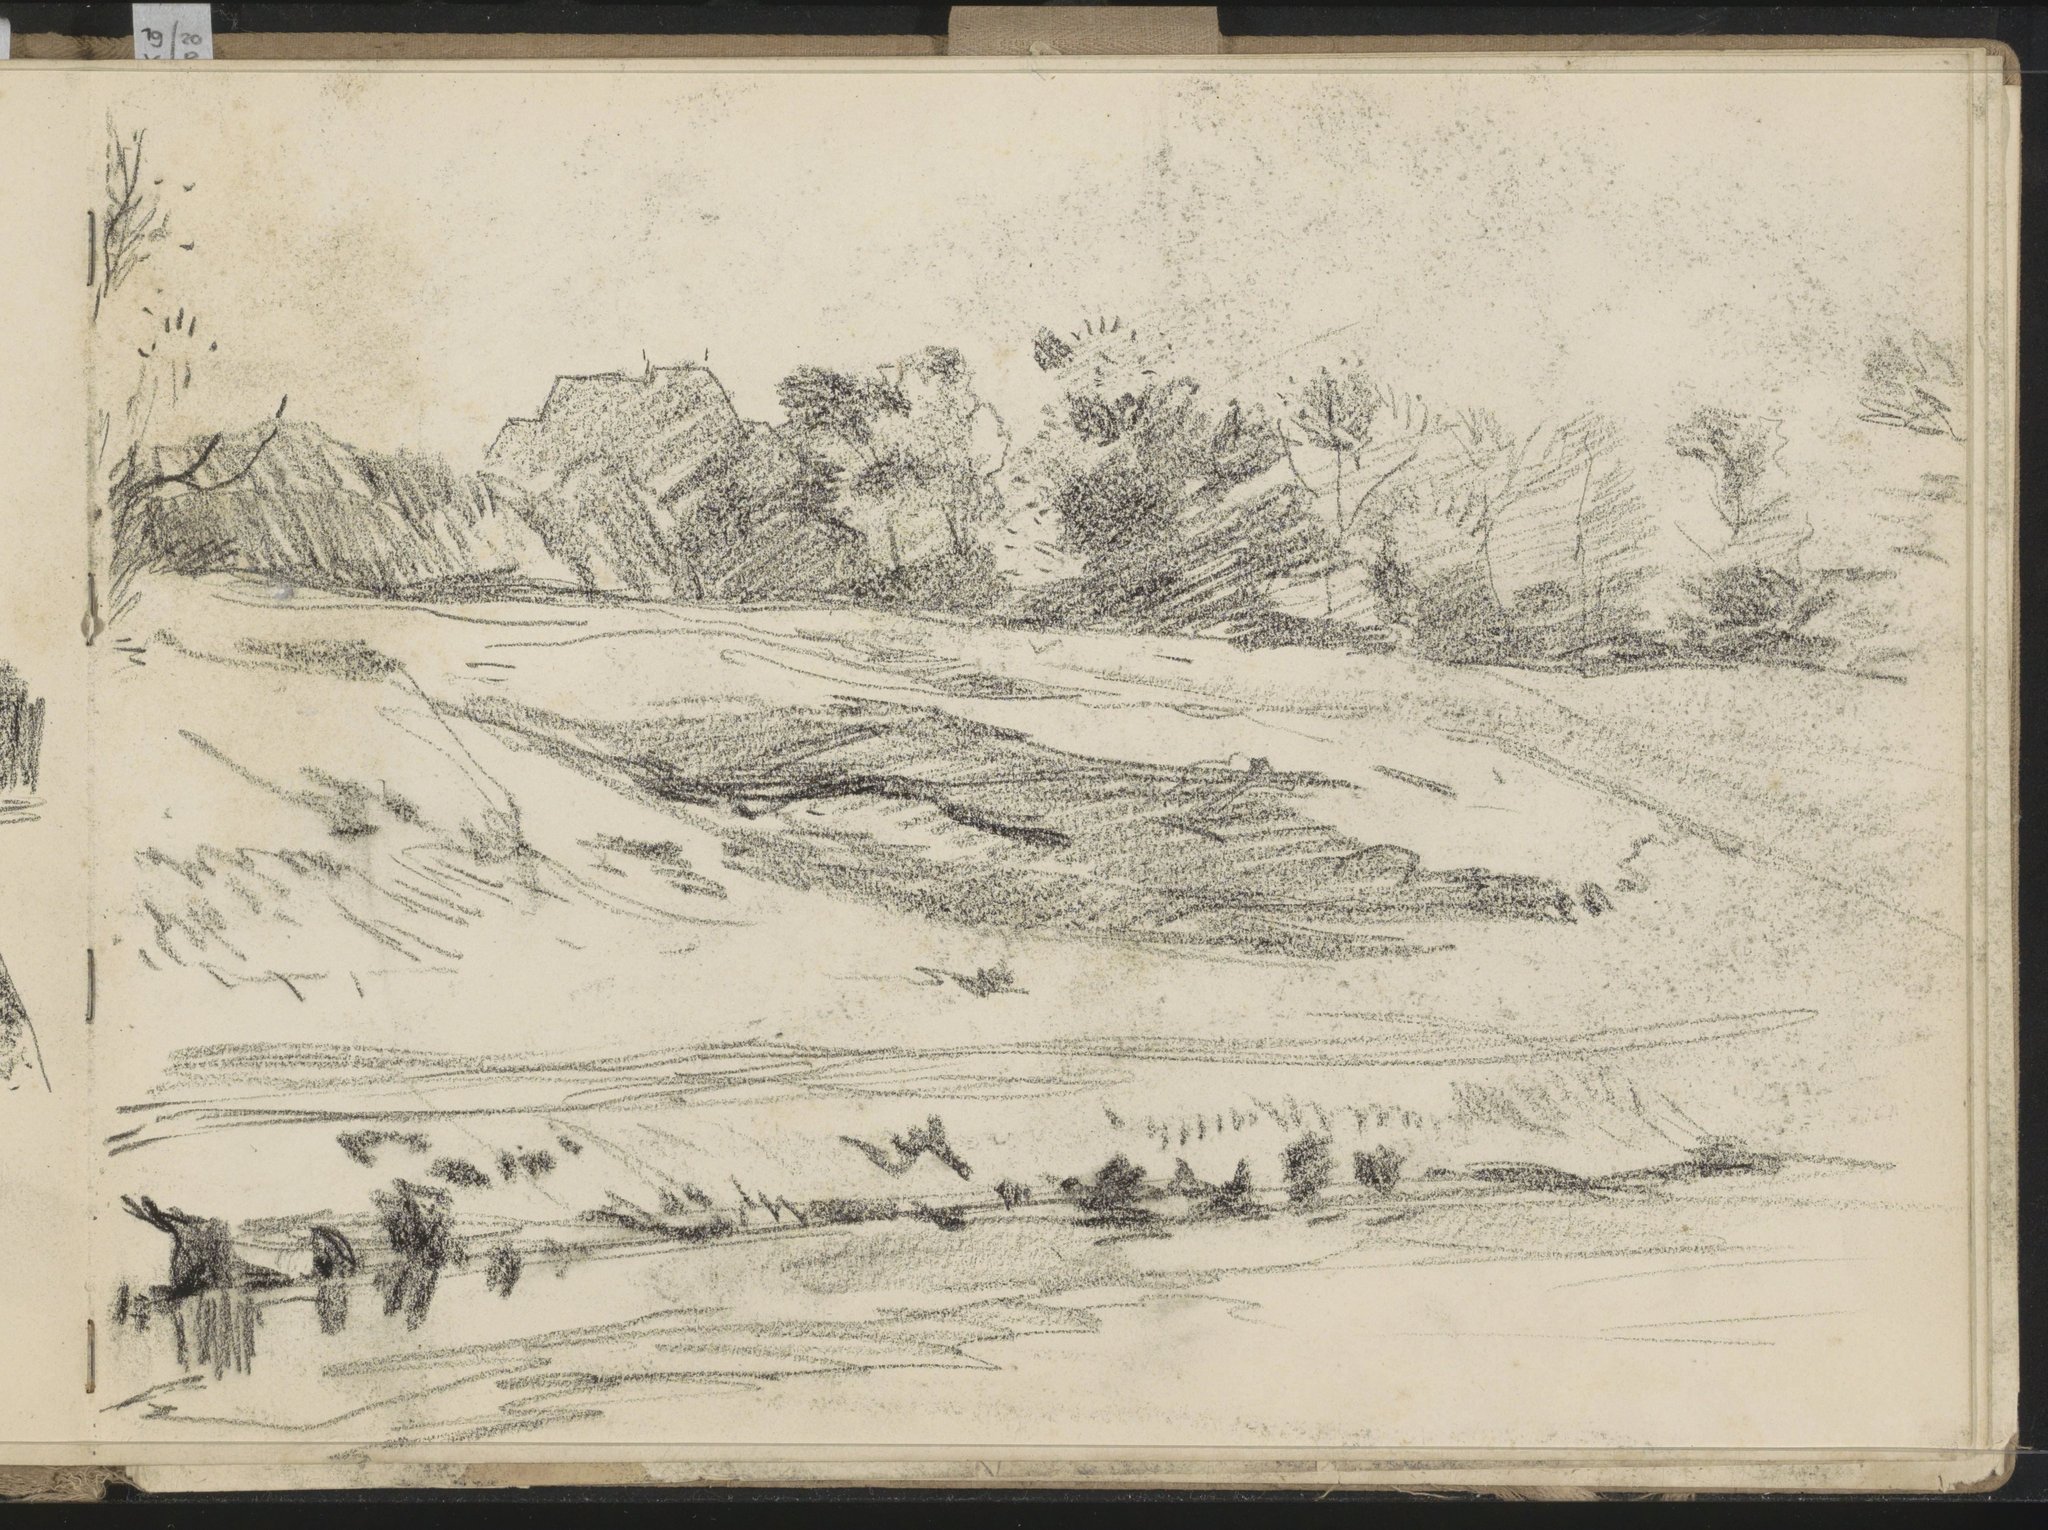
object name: sketchbook leaf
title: Landschap met bomen en weide aan een rivier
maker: willem bastiaan tholen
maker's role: draughtsman, painter, print maker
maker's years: 1860-1931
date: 1870-1931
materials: chalk, paper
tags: trees, river, landscapes with waters, waterscapes, seascapes (in the temperate zone), meadow, pasture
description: Blad 17 recto uit een schetsboek met 22 bladen.